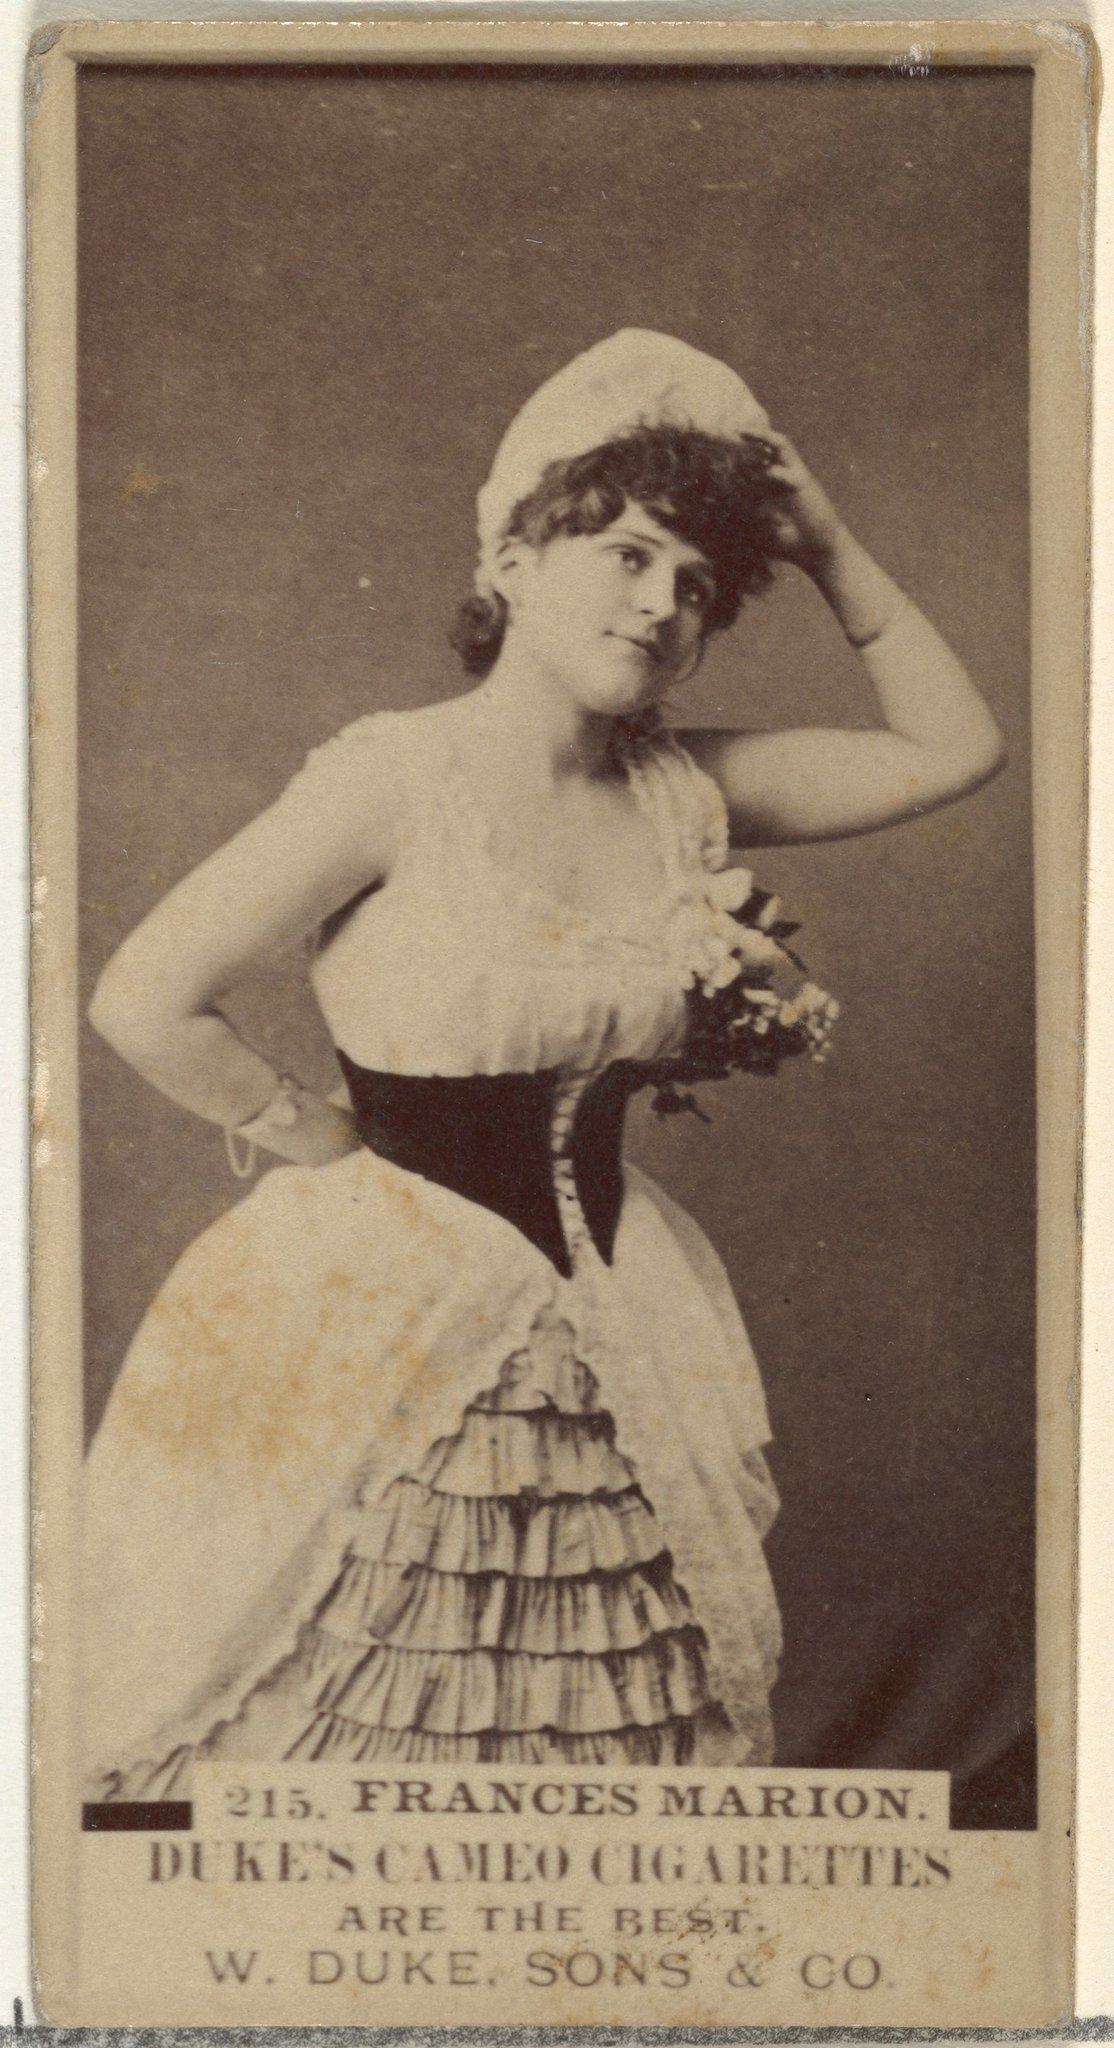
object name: photograph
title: Card Number 215, Frances Marion, from the Actors and Actresses series (N145-5) issued by Duke Sons & Co. to promote Cameo Cigarettes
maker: w. duke, sons & co.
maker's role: publisher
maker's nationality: american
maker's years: 1870-1920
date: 1880-1889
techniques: albumen silver print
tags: portraits,women,actresses